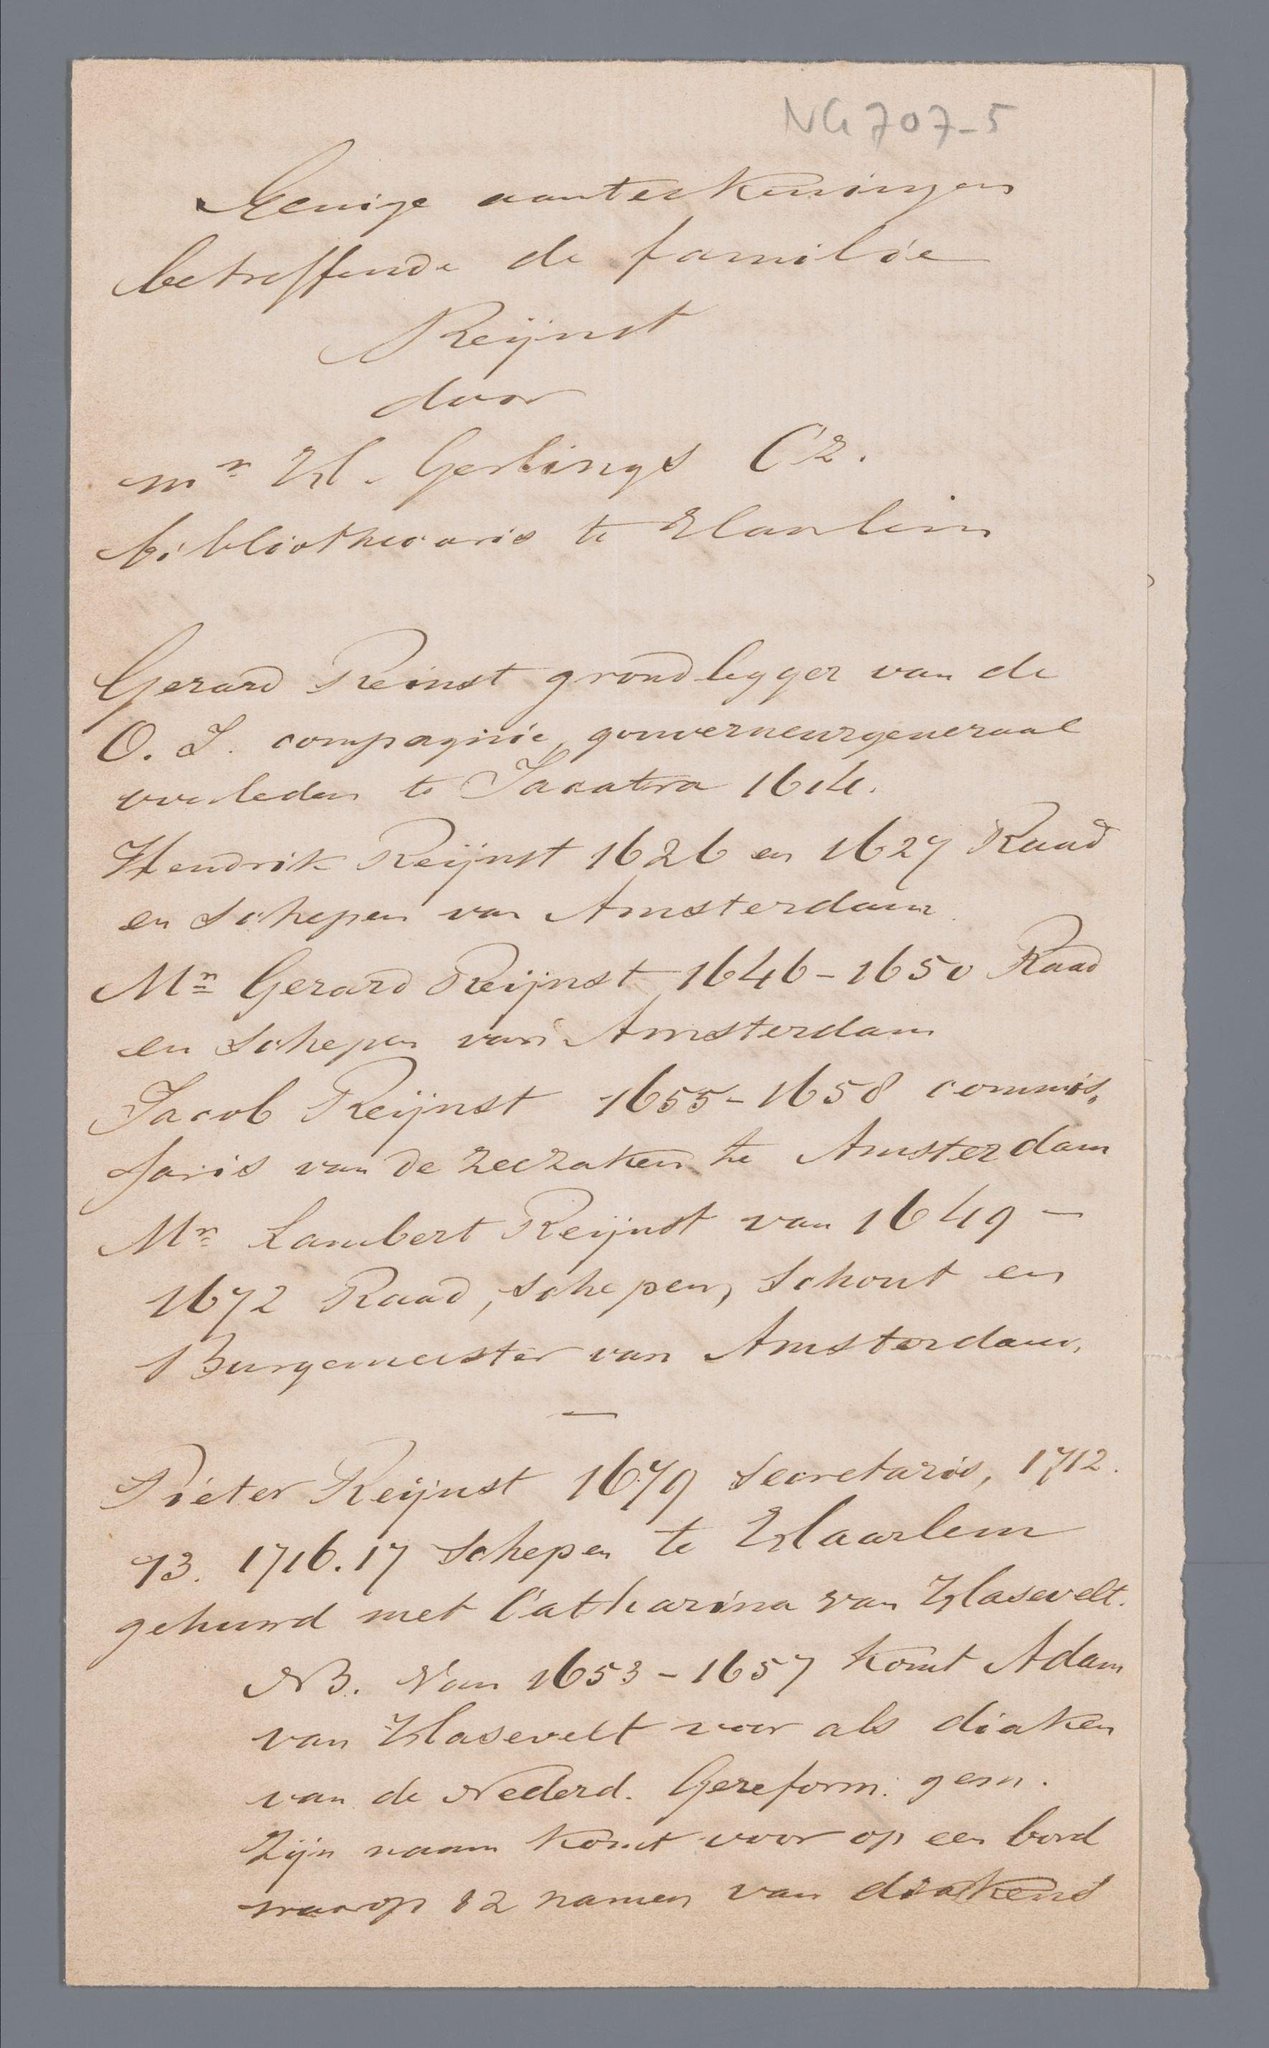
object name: document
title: Eenige aanteekeningen betreffende de familie Reynst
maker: cz gerlings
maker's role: schrijver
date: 1775-1800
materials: ink, paper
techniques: writing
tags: reynst, familie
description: Dubbelgevouwen blad papier, op drie pp beschreven met aantekeningen.